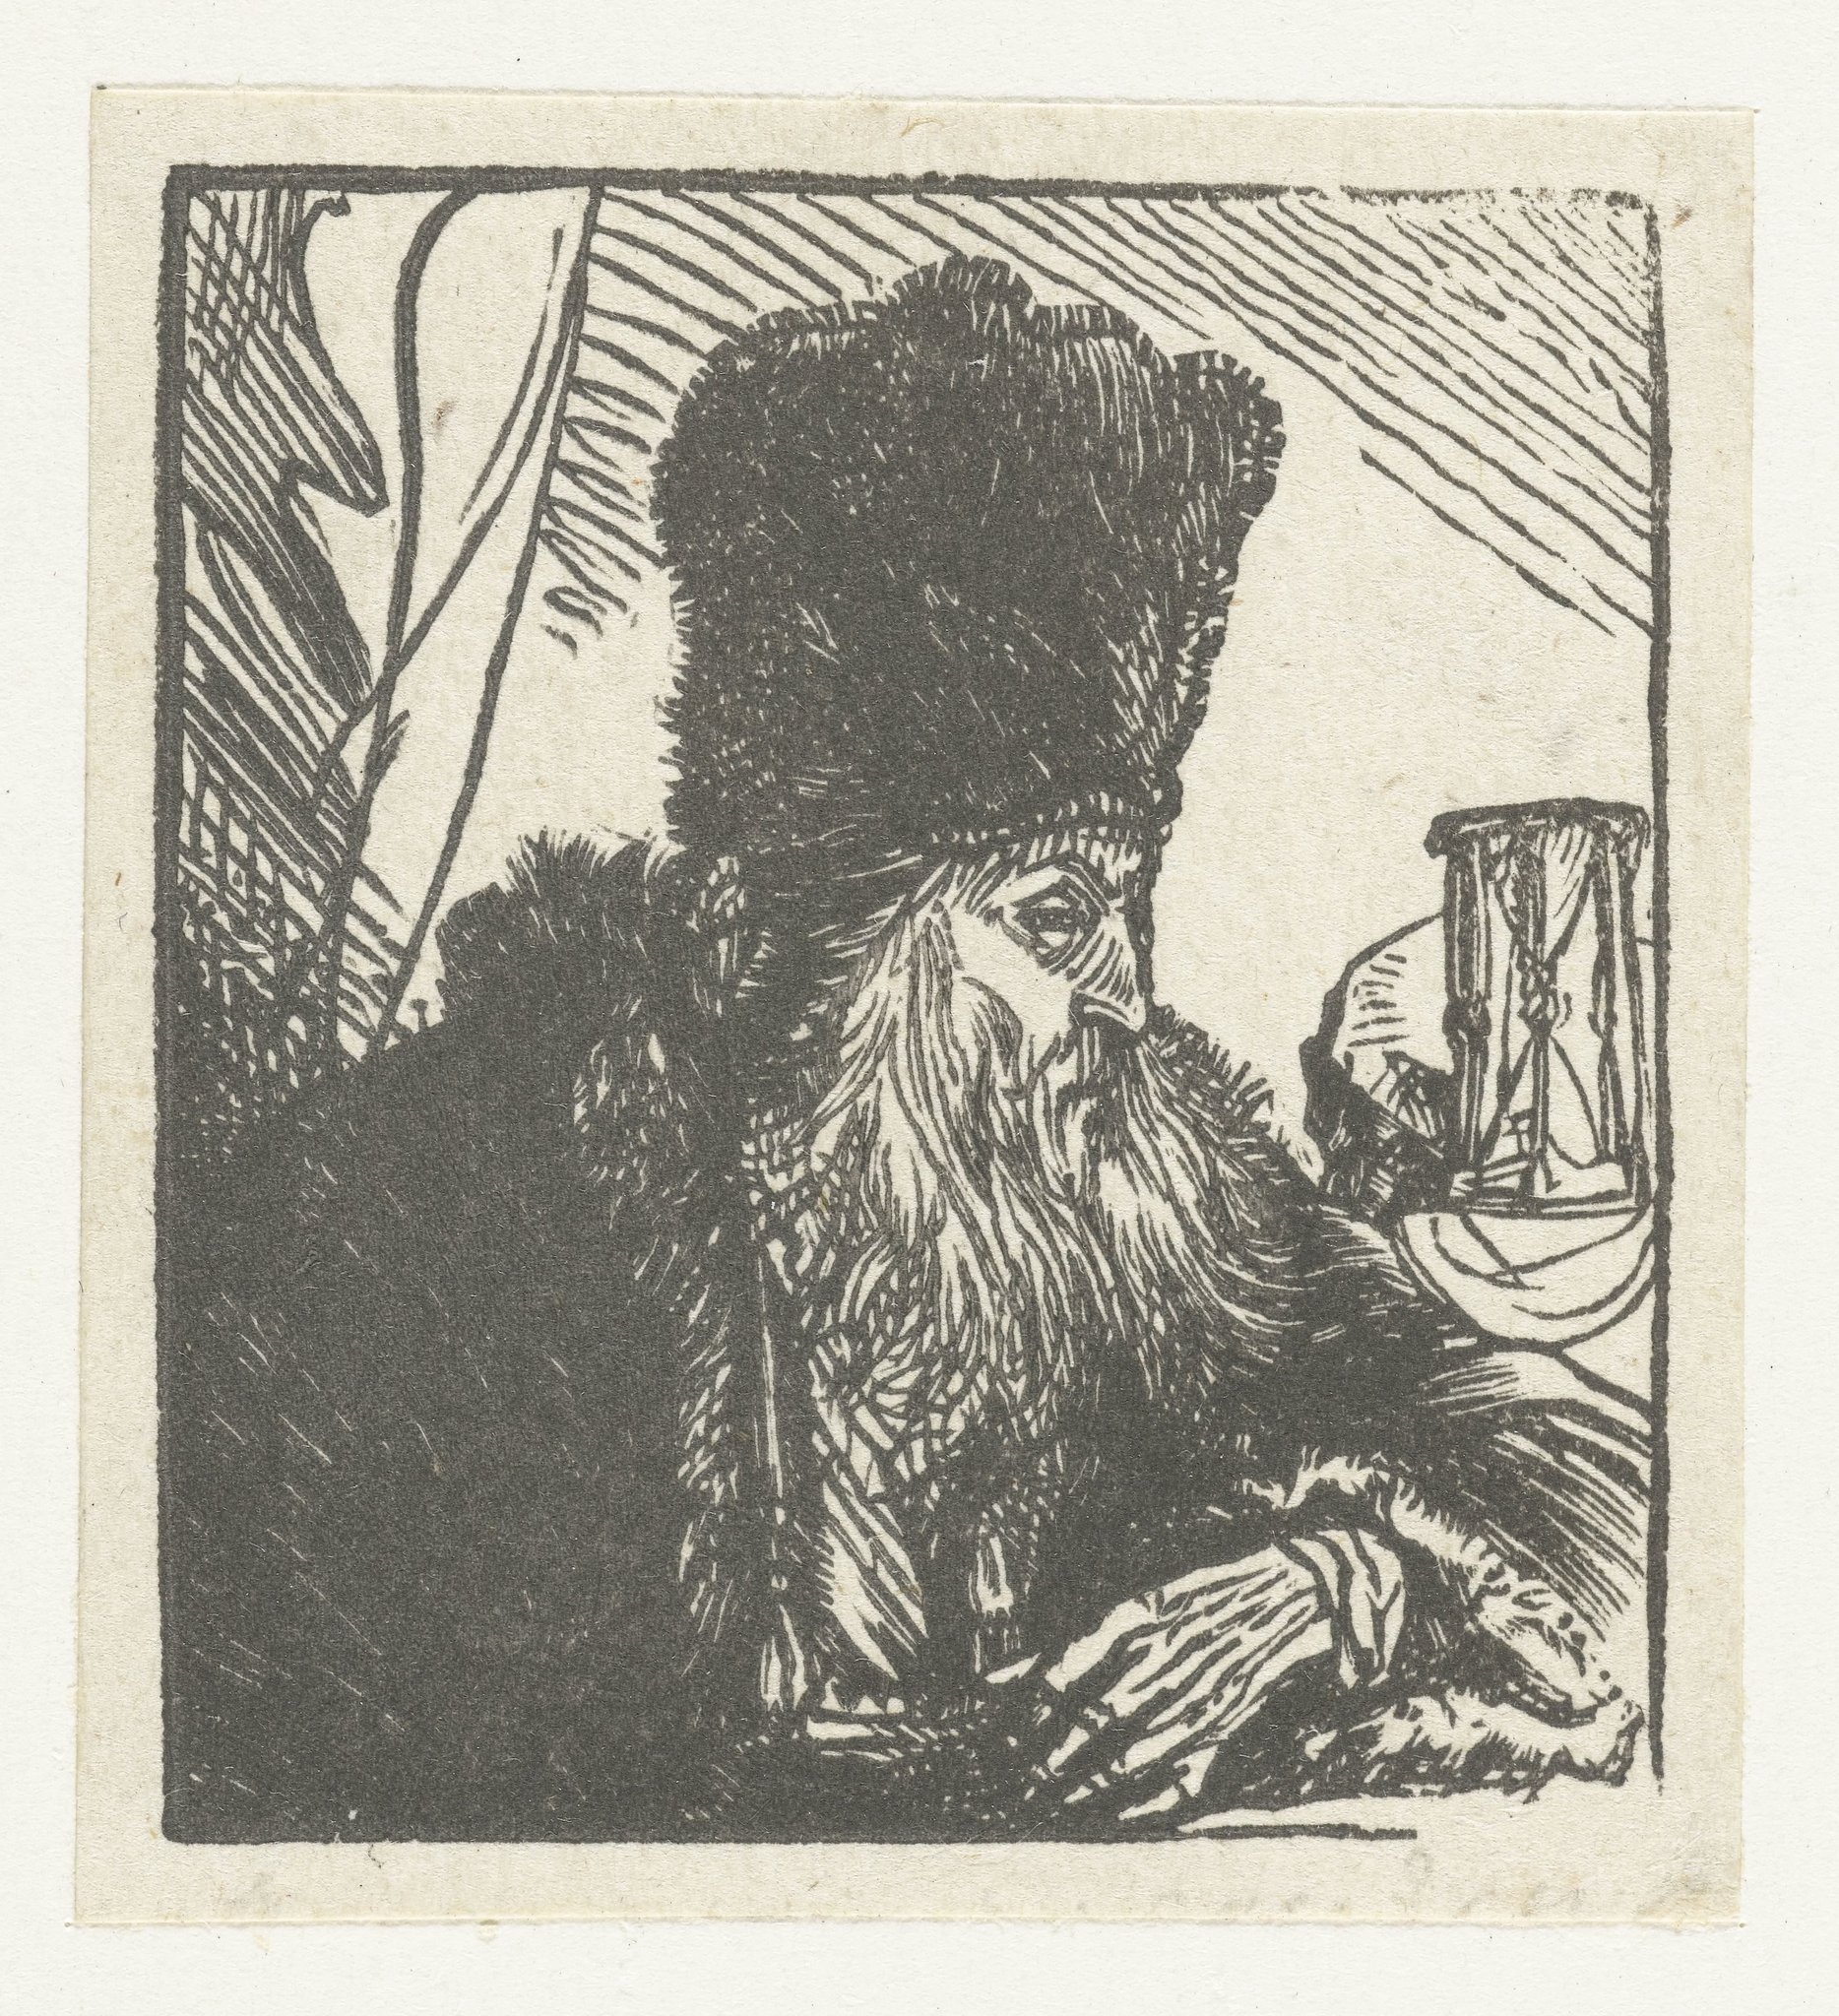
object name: print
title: Geleerde met een zandloper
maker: Anonymous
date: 1625-1674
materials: paper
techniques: woodcut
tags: scholar, philosopher, hourglass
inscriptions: collector's mark: Lugt 240